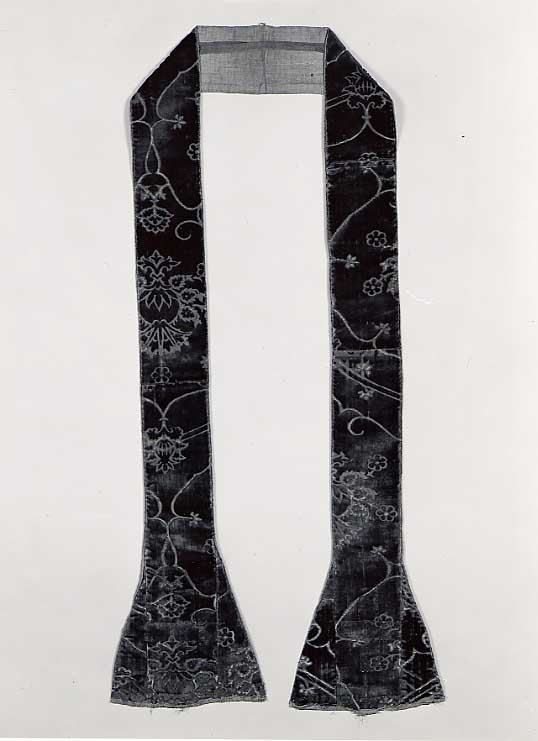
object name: stole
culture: italian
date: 1434-1466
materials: textile, silk